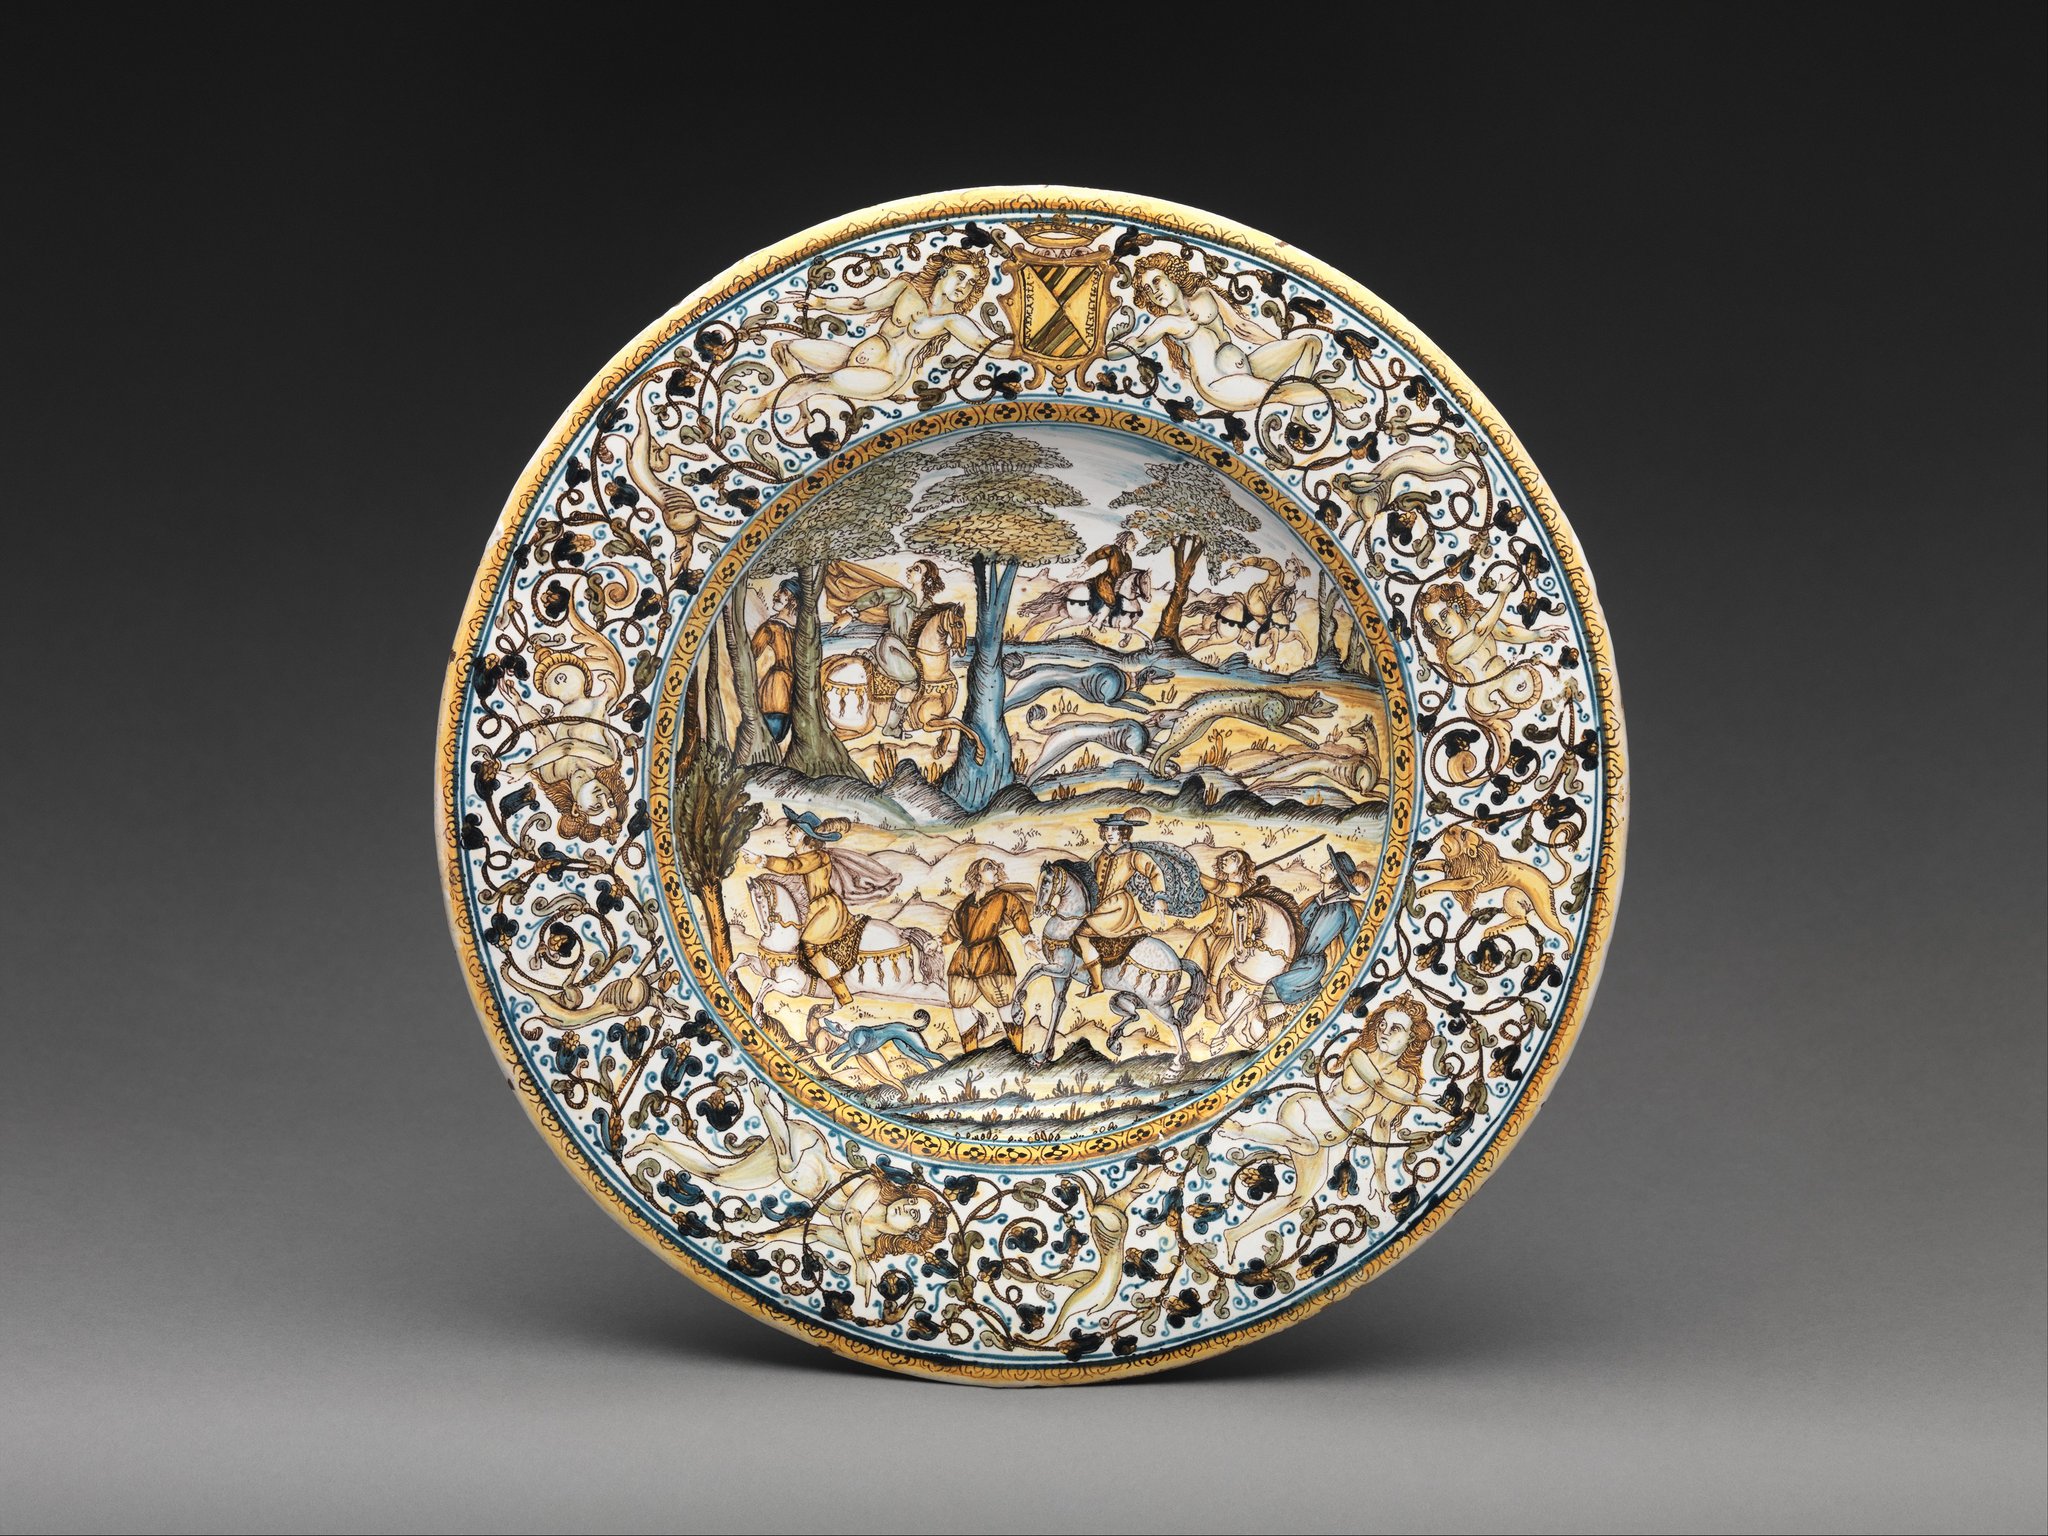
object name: plate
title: Plate with hunting scene and arms of the Alarçon y Mendoza family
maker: francesco grue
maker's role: artist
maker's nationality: italian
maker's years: 1618-1673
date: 1640-1650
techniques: maiolica, glazing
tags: female nudes,hunting,horses,coat of arms